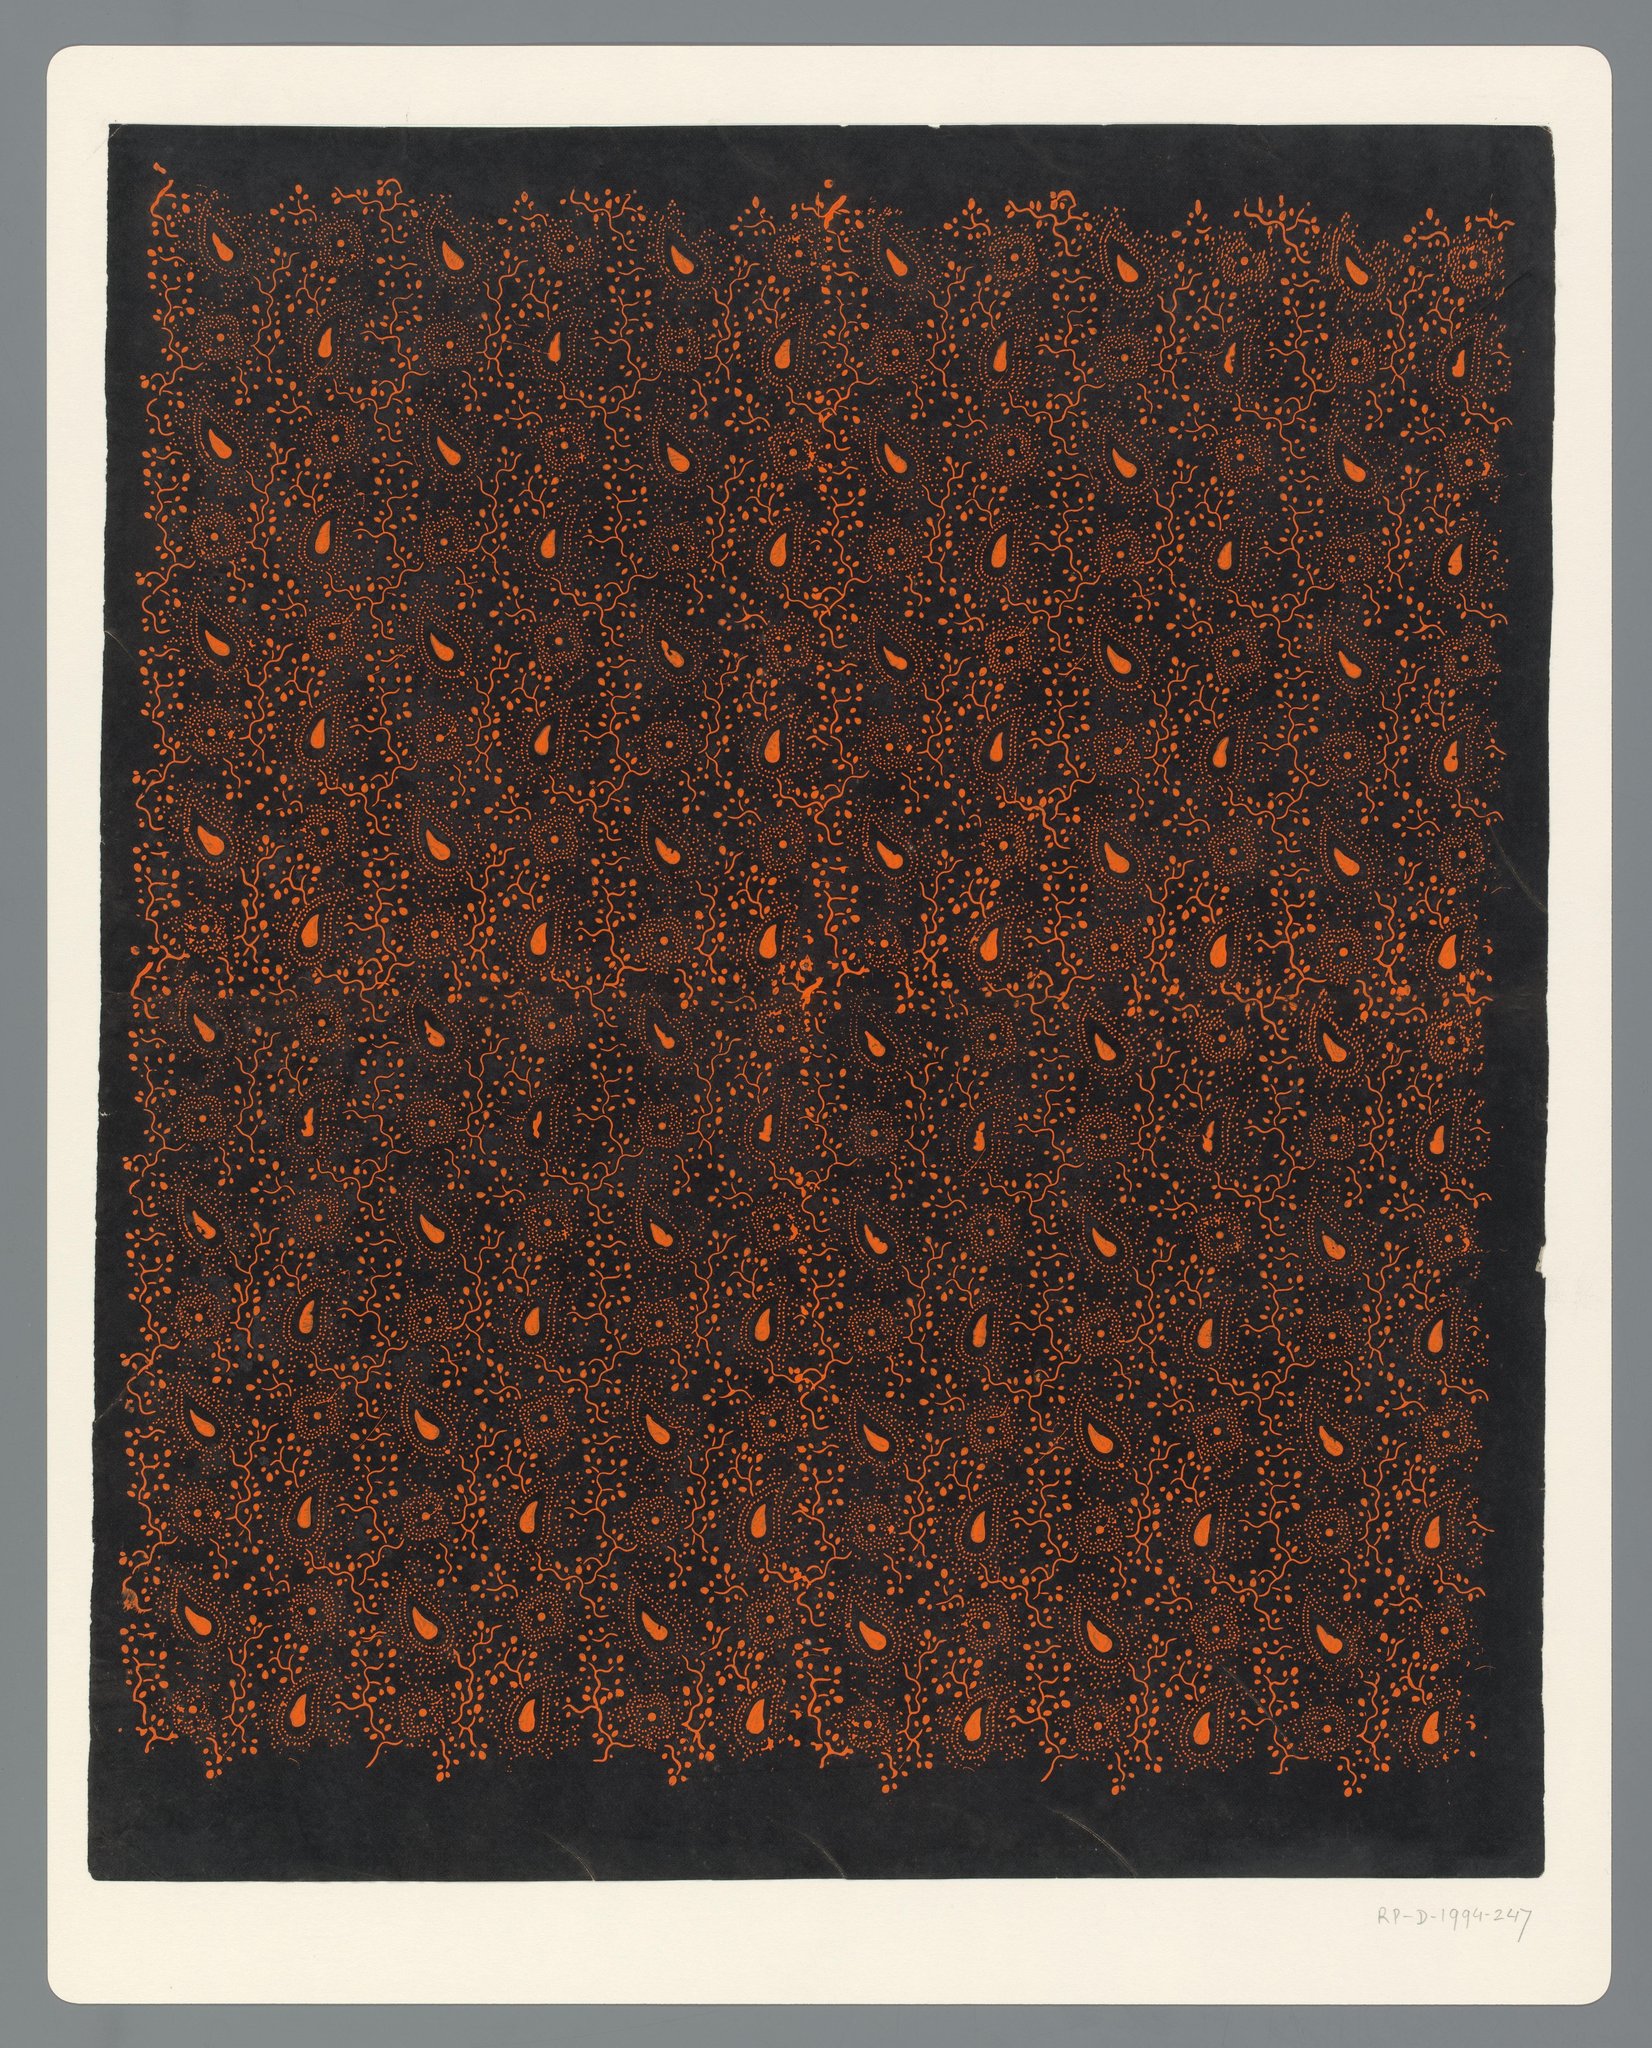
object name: printed paper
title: Blad met strooipatroon van bladmotief tussen stippen en ranken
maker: Anonymous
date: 1860-1920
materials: lacquer, paint, paper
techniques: printing block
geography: aschaffenburg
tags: ornament derived from plant forms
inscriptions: collector's mark: Lugt 2228